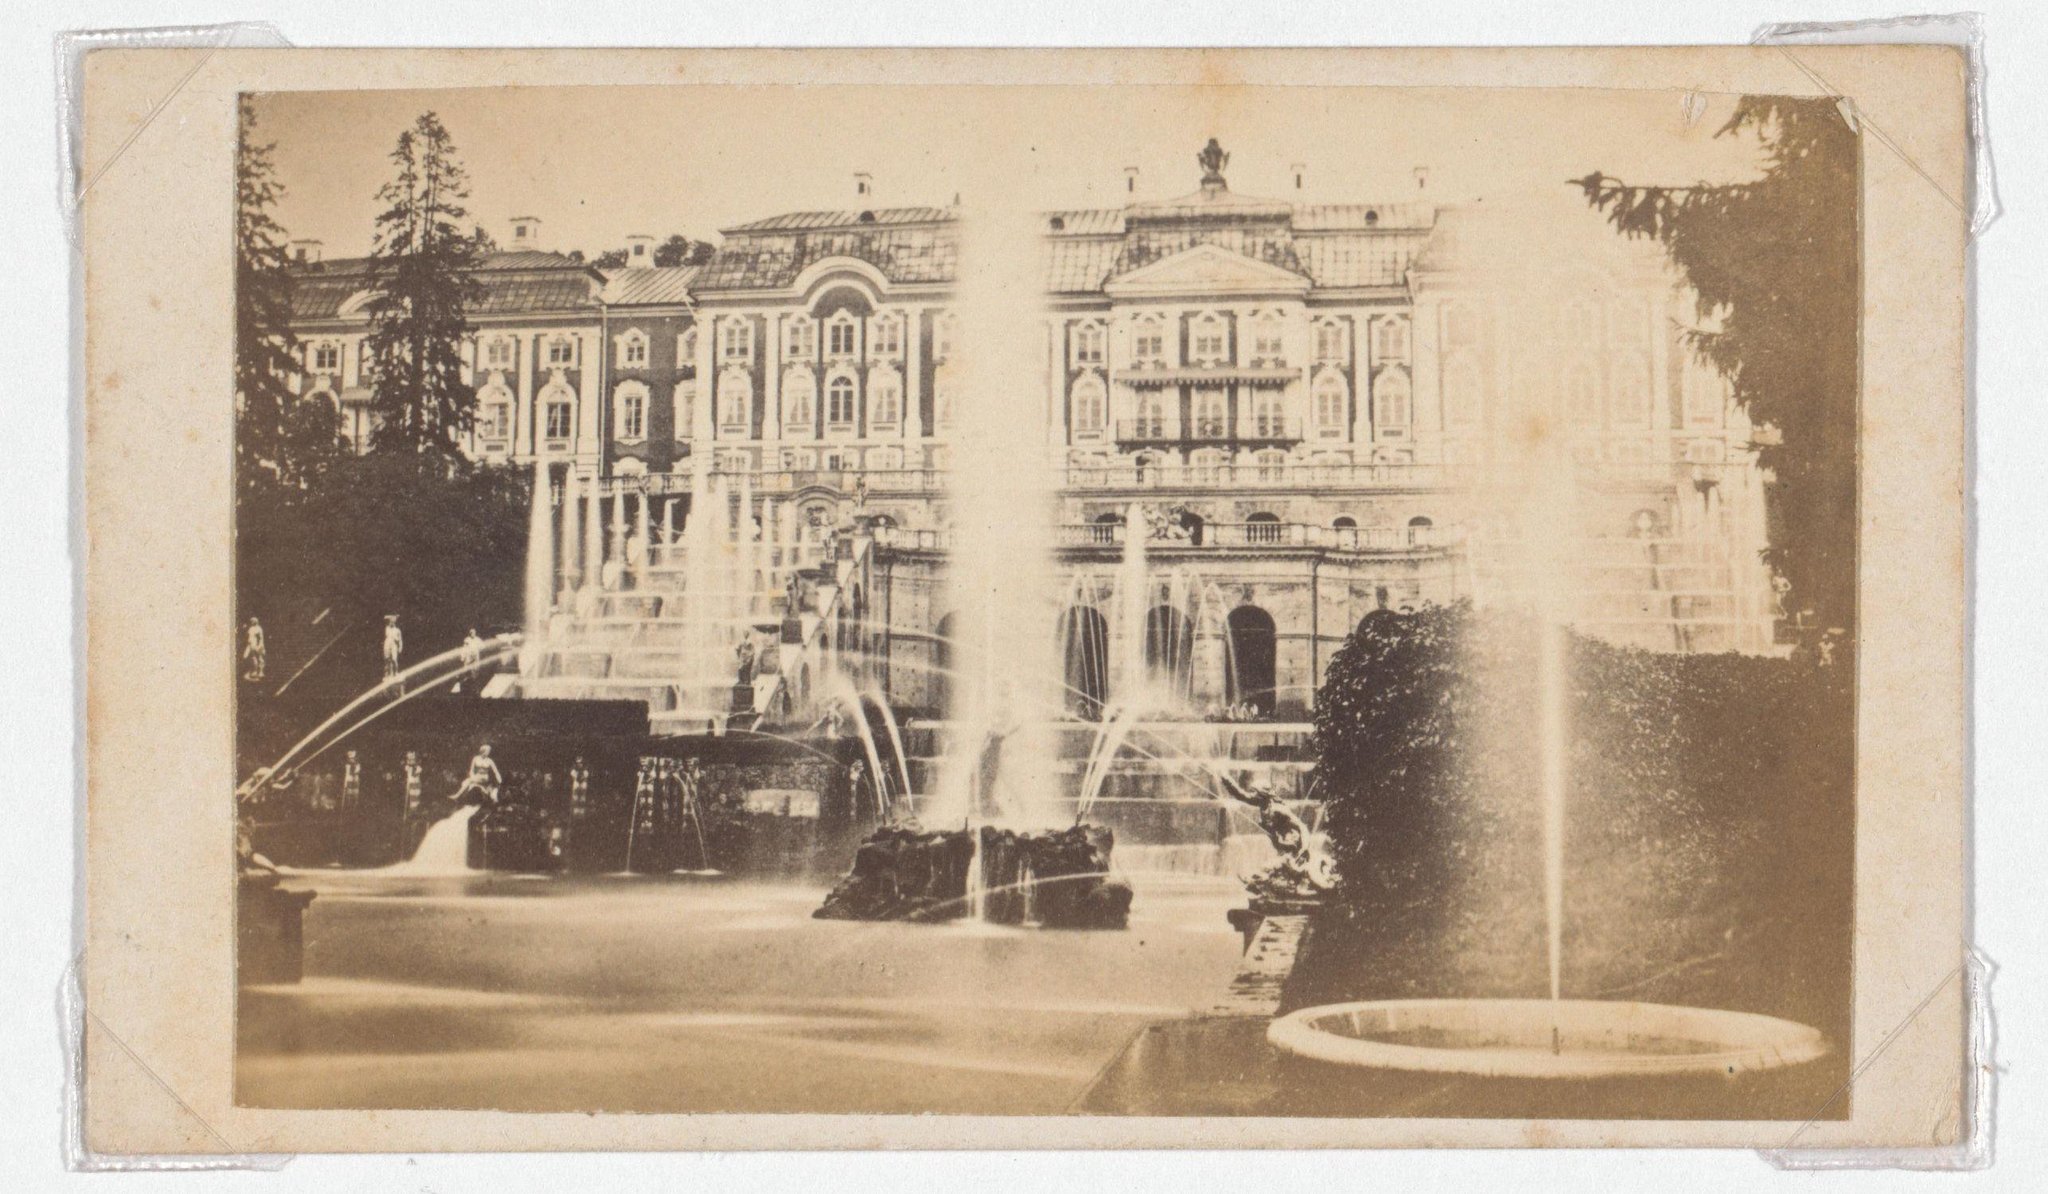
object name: photograph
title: Paleis met fonteinen in Peterhof (Sint Petersburg)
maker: Anonymous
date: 1880-1900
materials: cardboard, paper, photographic support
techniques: albumen print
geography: sint-petersburg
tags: palace